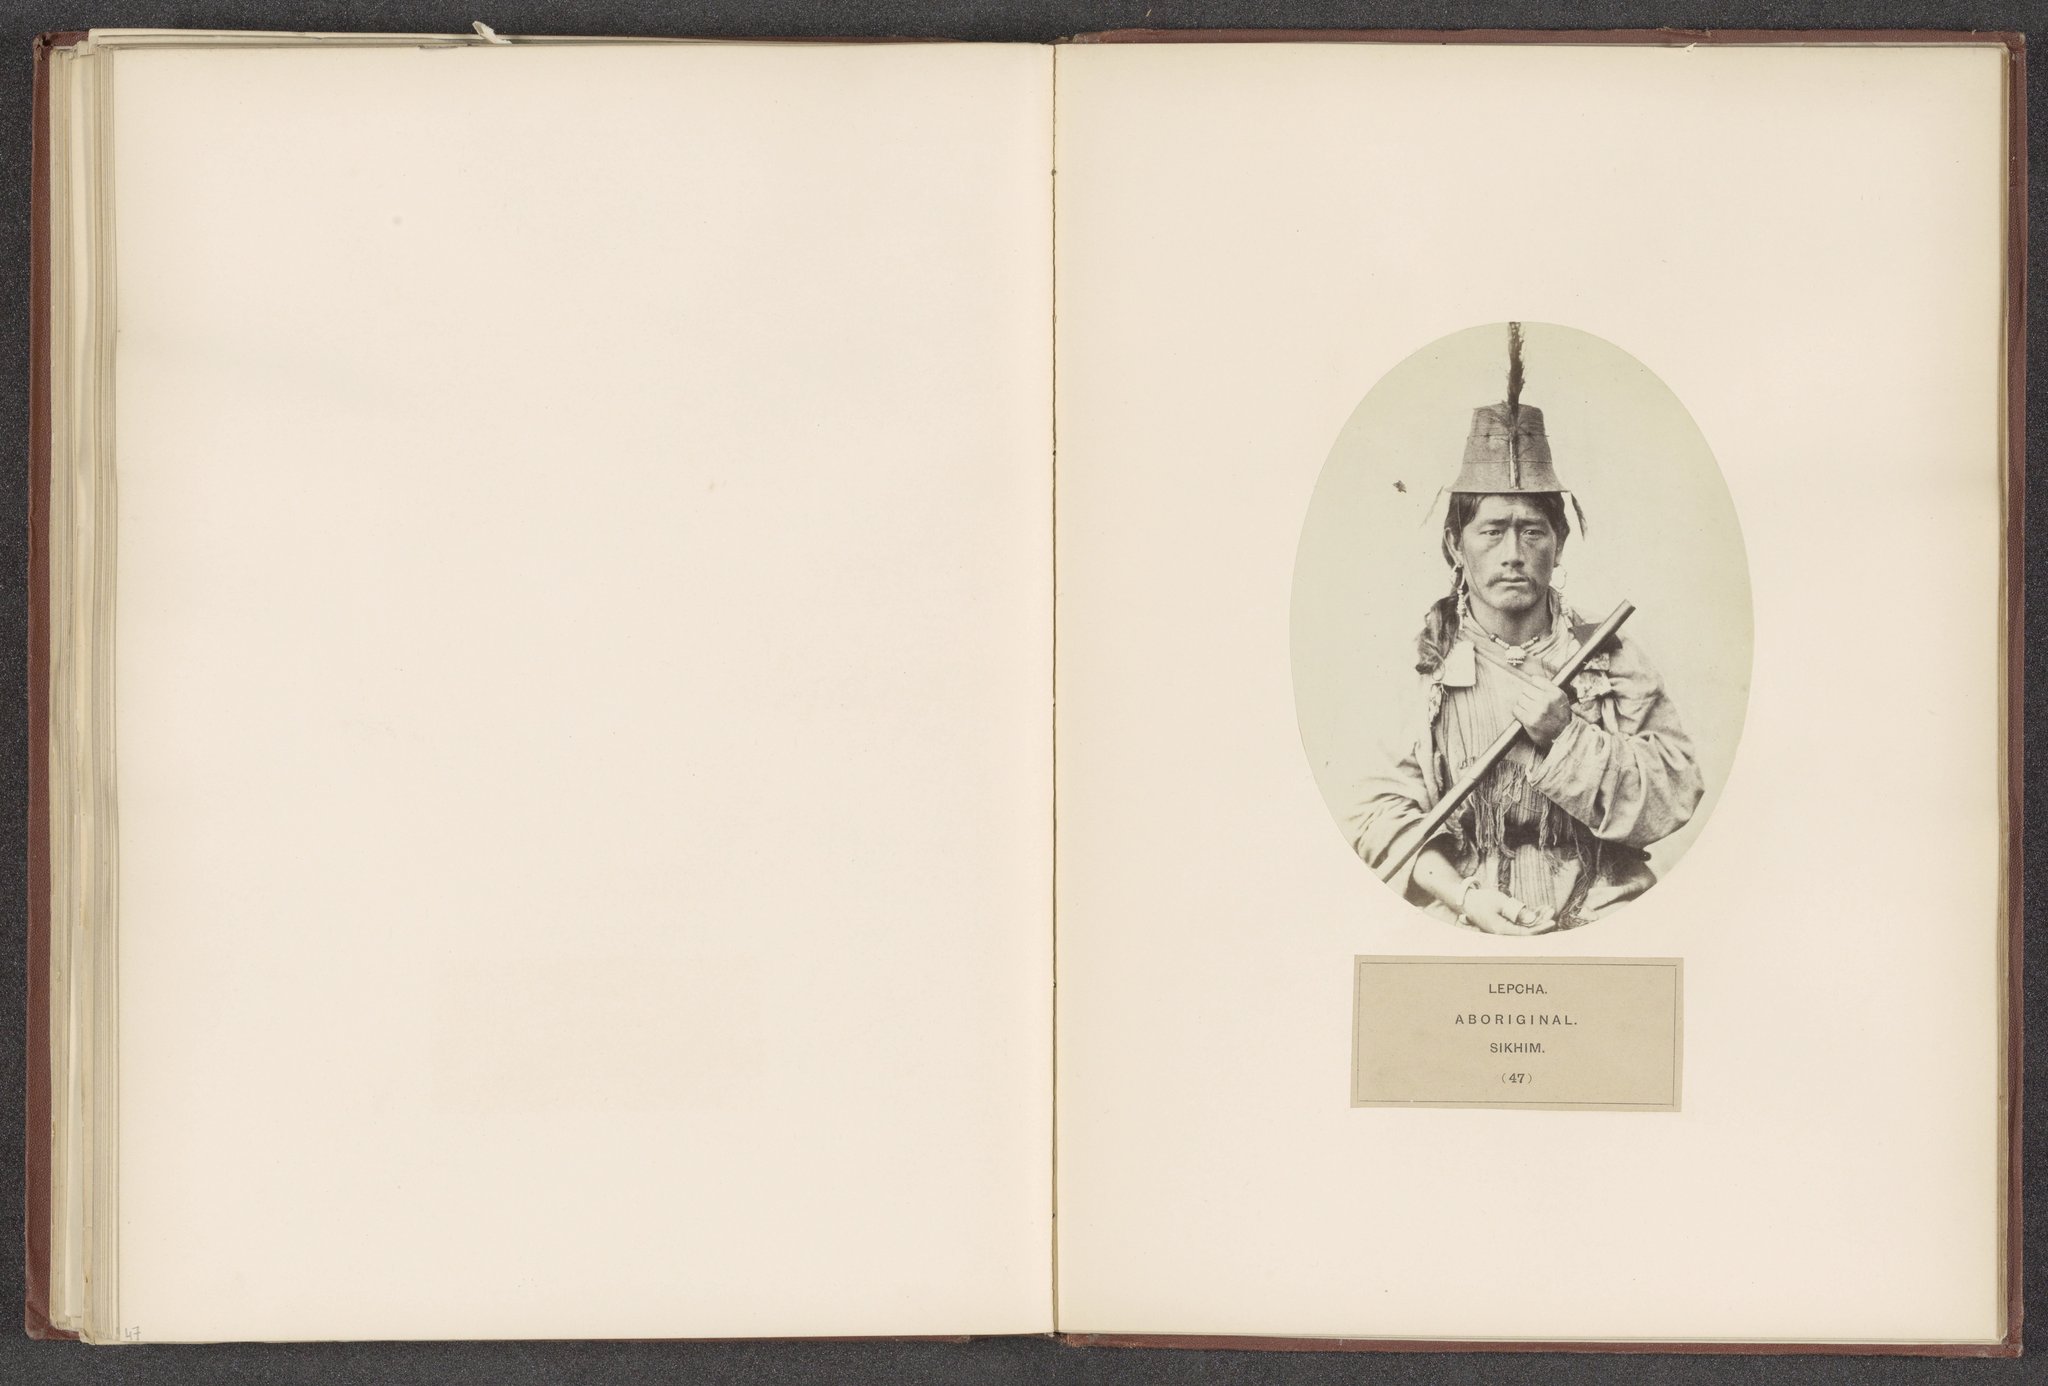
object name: page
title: Portrait of an unknown man with a weapon from the Lepcha community of Sikkim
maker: benjamin simpson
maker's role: fotograaf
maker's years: 1831-1923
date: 1858-1868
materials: photographic support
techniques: albumen print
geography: sikkim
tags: head-gear: hat, human races; peoples; nationalities, casting weapons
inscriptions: inscription: ‘LEPCHA./ ABORIGINAL./ SIKHIM.’, number: ‘(47)’